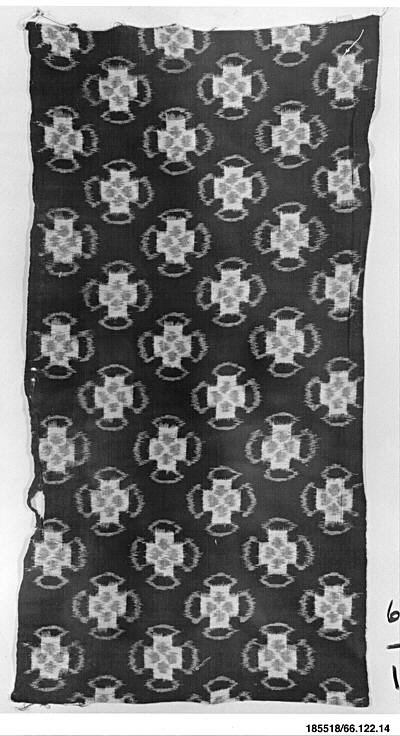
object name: piece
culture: japanese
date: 1801-1900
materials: cotton